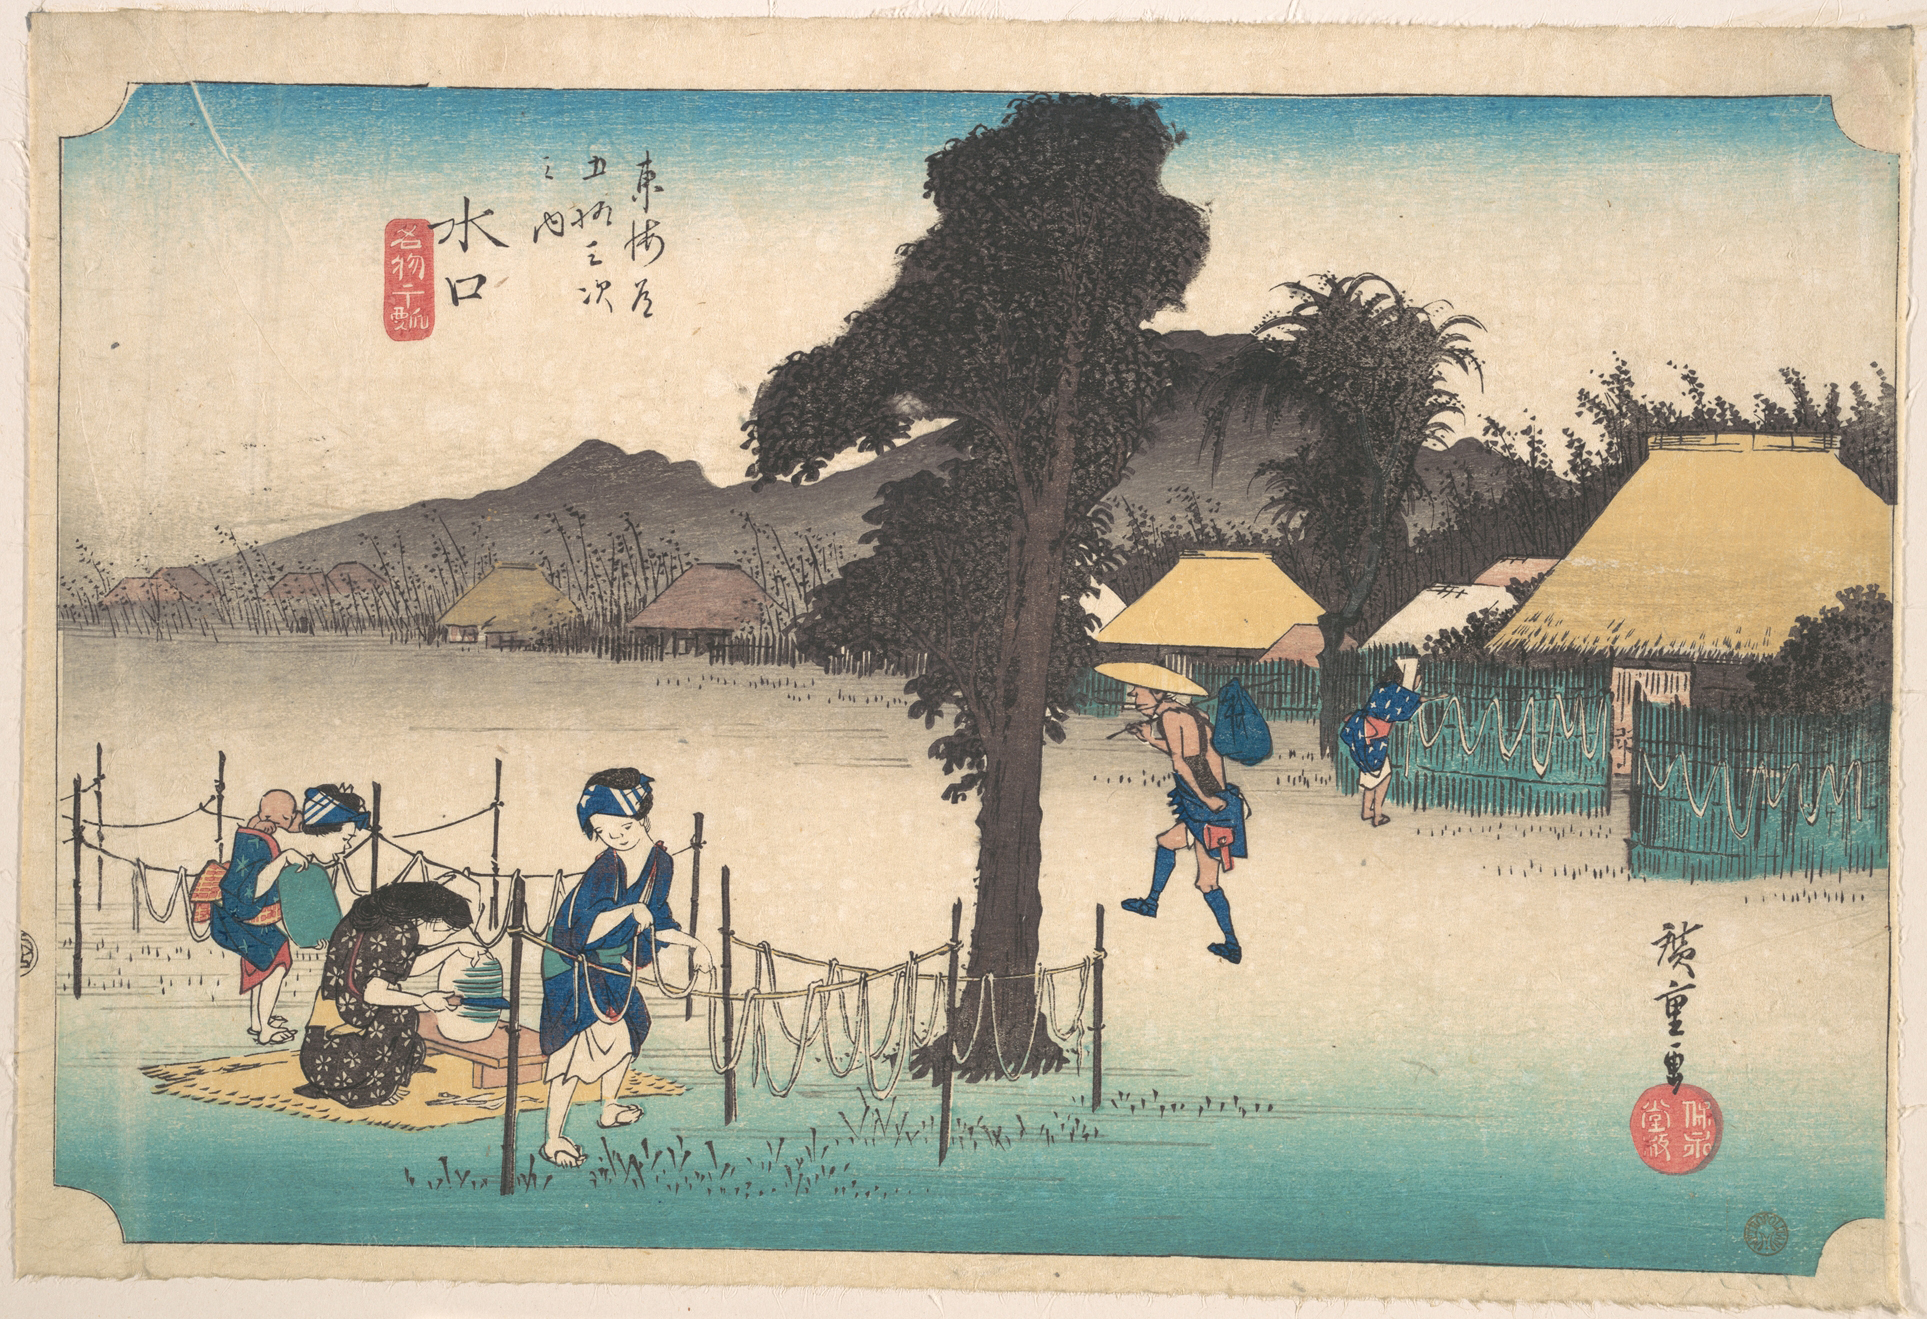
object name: print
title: Mizukuchi, Meibutsu Kampyo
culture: japanese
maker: utagawa hiroshige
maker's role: artist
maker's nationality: japanese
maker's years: 1797-1858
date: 1834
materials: ink, paper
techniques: woodblock print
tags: houses,men,women,mountains,trees